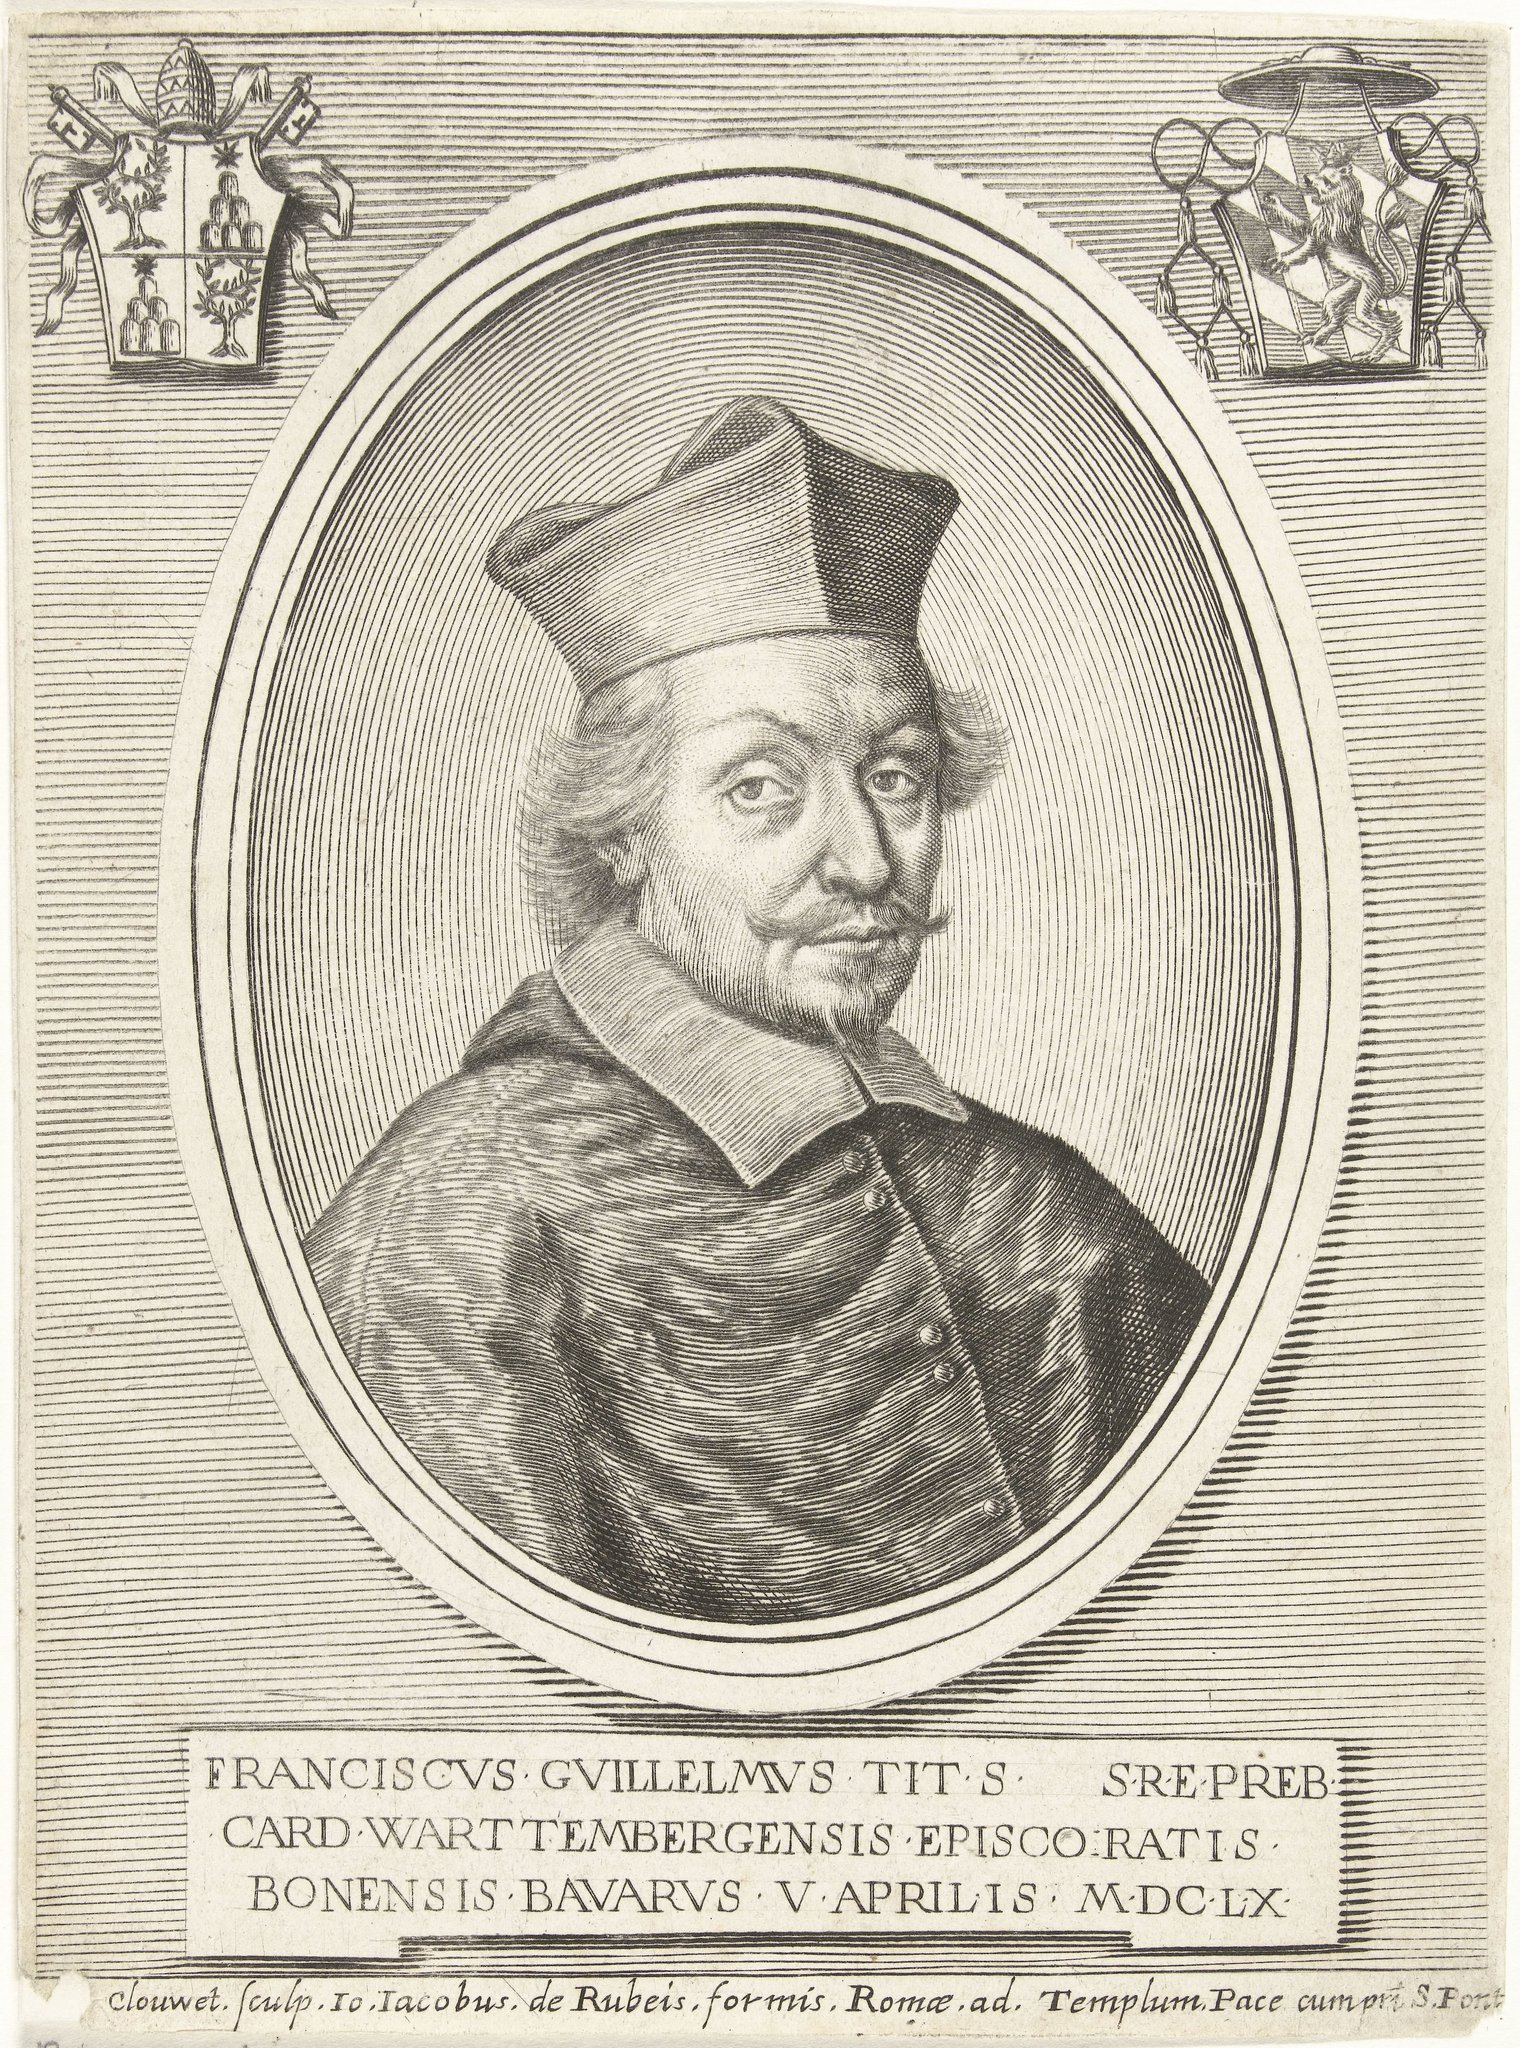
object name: print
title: Portretten van kardinalen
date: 1661-1679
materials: paper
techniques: engraving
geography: rome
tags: priest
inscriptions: collector's mark: Lugt 2228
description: Portret in ovale lijst van kardinaal Franz Wilhelm von Wartenberg. Buste naar rechts. Bovenaan links het wapen van paus Alexander VII, bovenaan rechts het wapen van kardinaal Franz Wilhelm von Wartenberg. De prent heeft een Latijns onderschrift met gegevens over de geportretteerde.